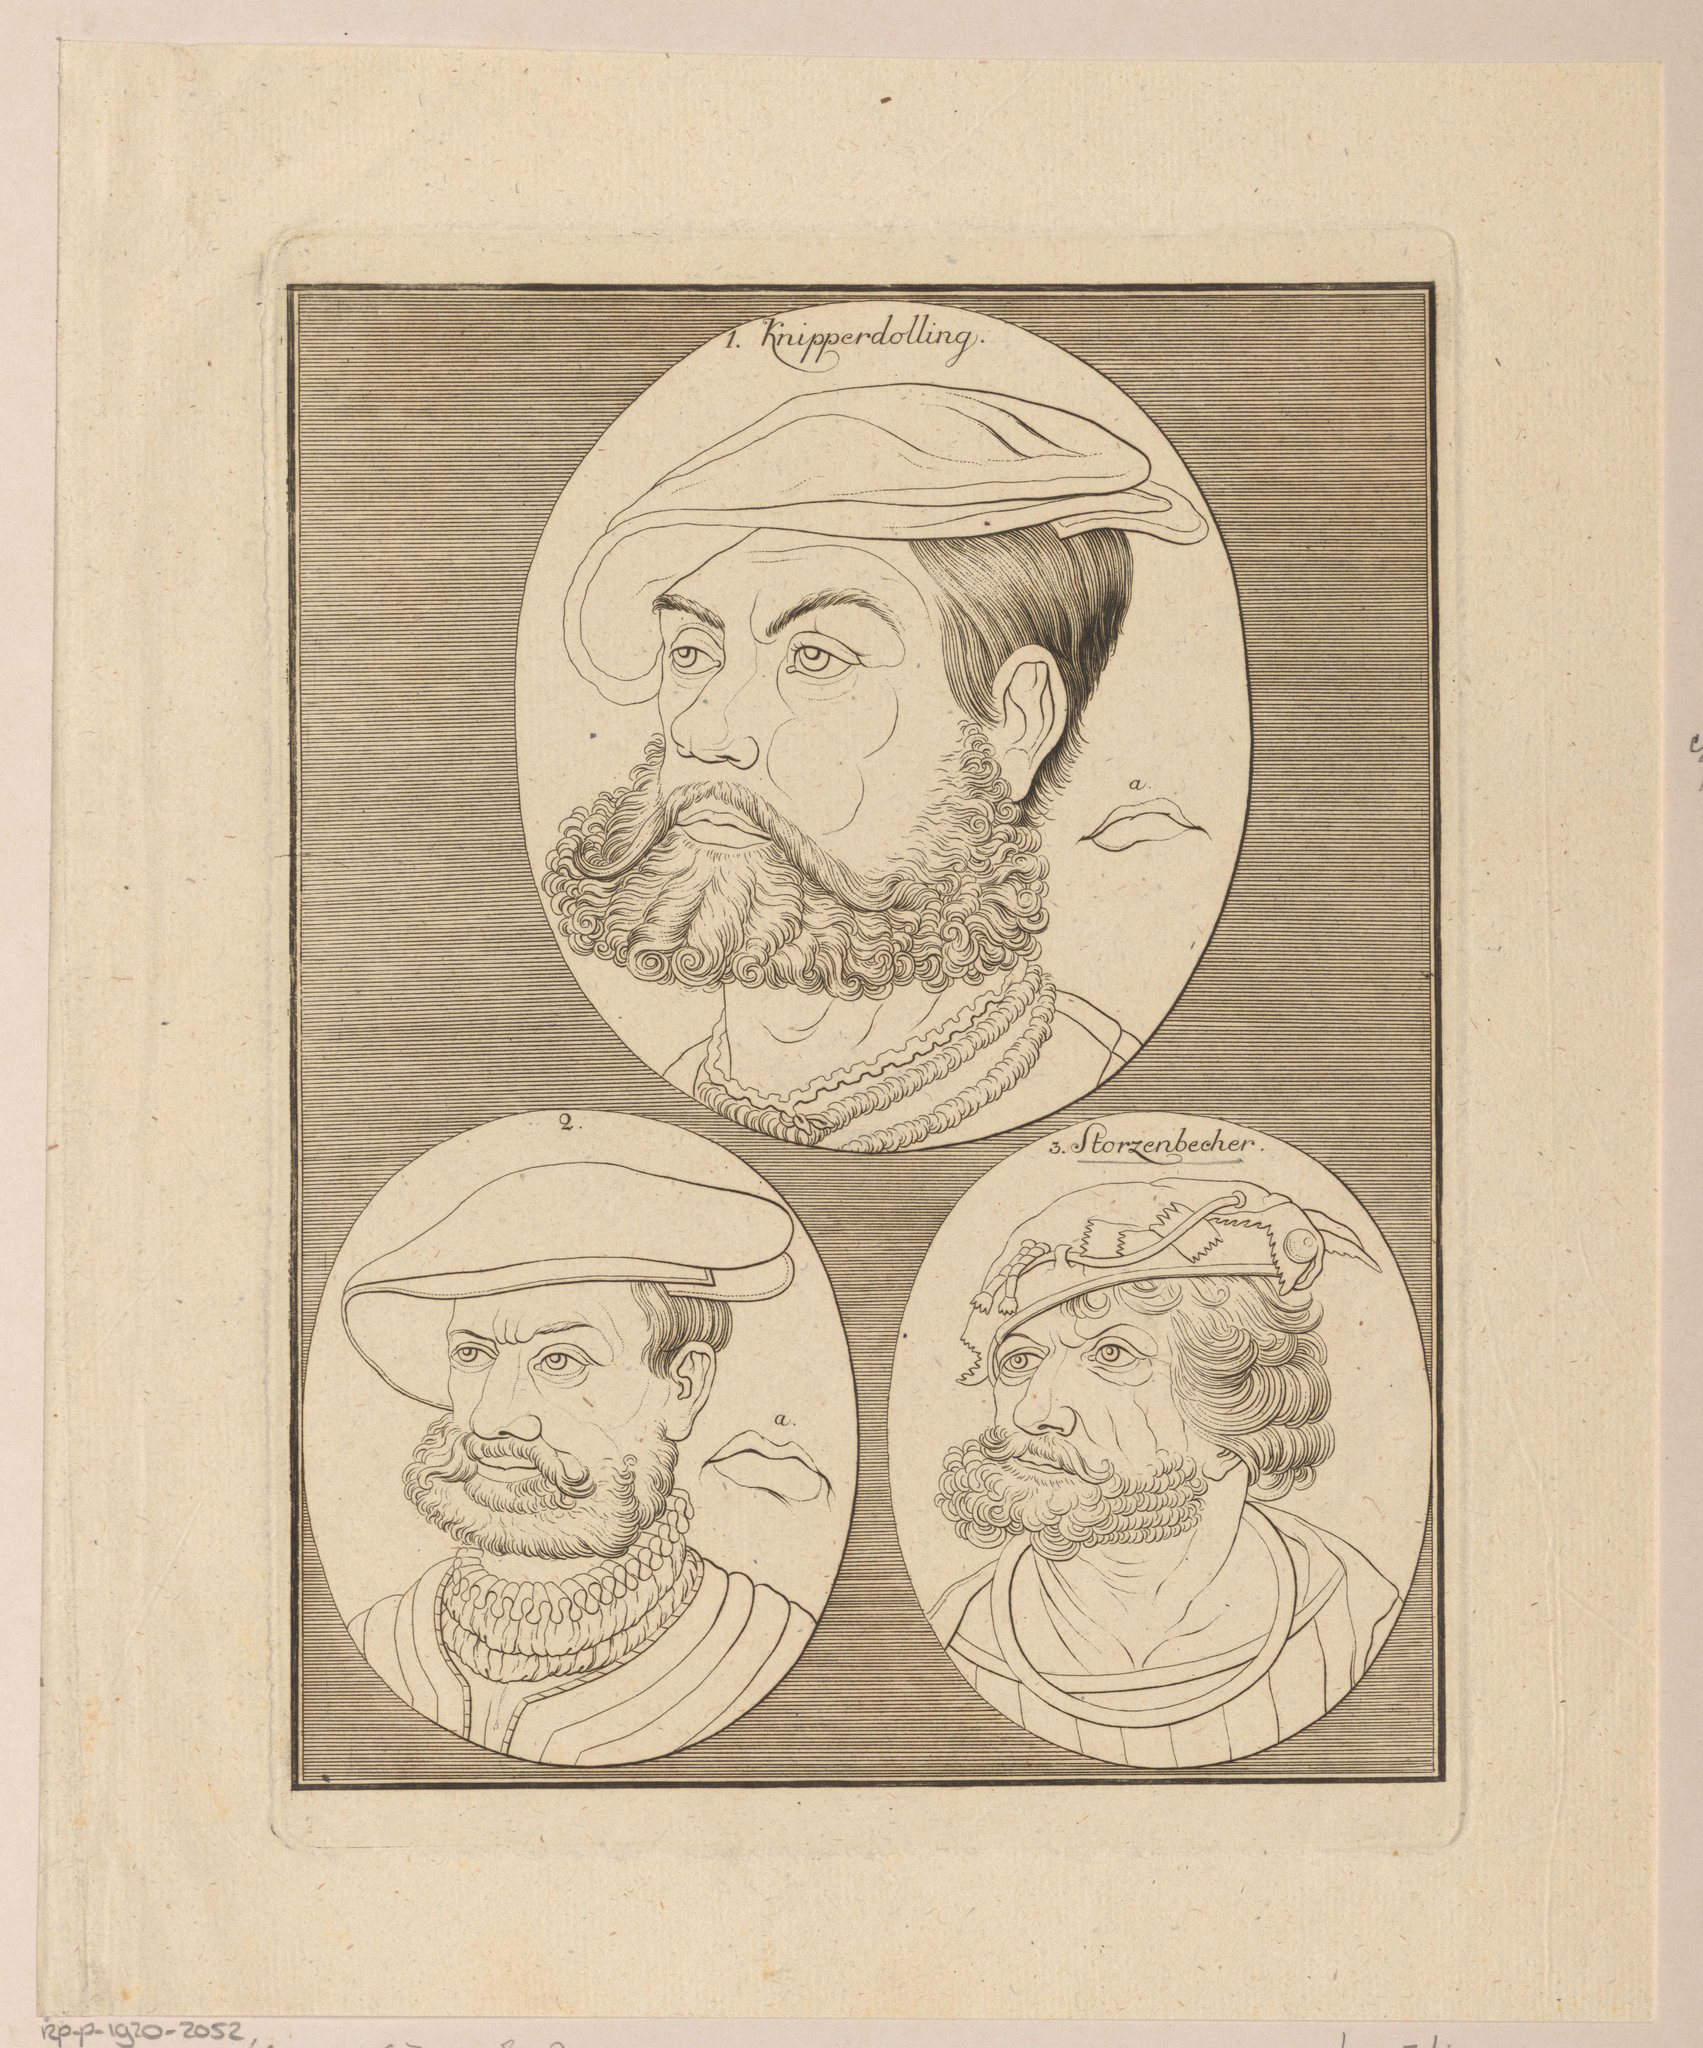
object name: print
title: Portretten van Bernardus Knipperdolling, Klaus Störtebeker en een onbekende man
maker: Anonymous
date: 1700-1850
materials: paper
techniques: etching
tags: pirate, corsair, buccaneer, historical persons, merchant, salesman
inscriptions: collector's mark: Lugt 2228